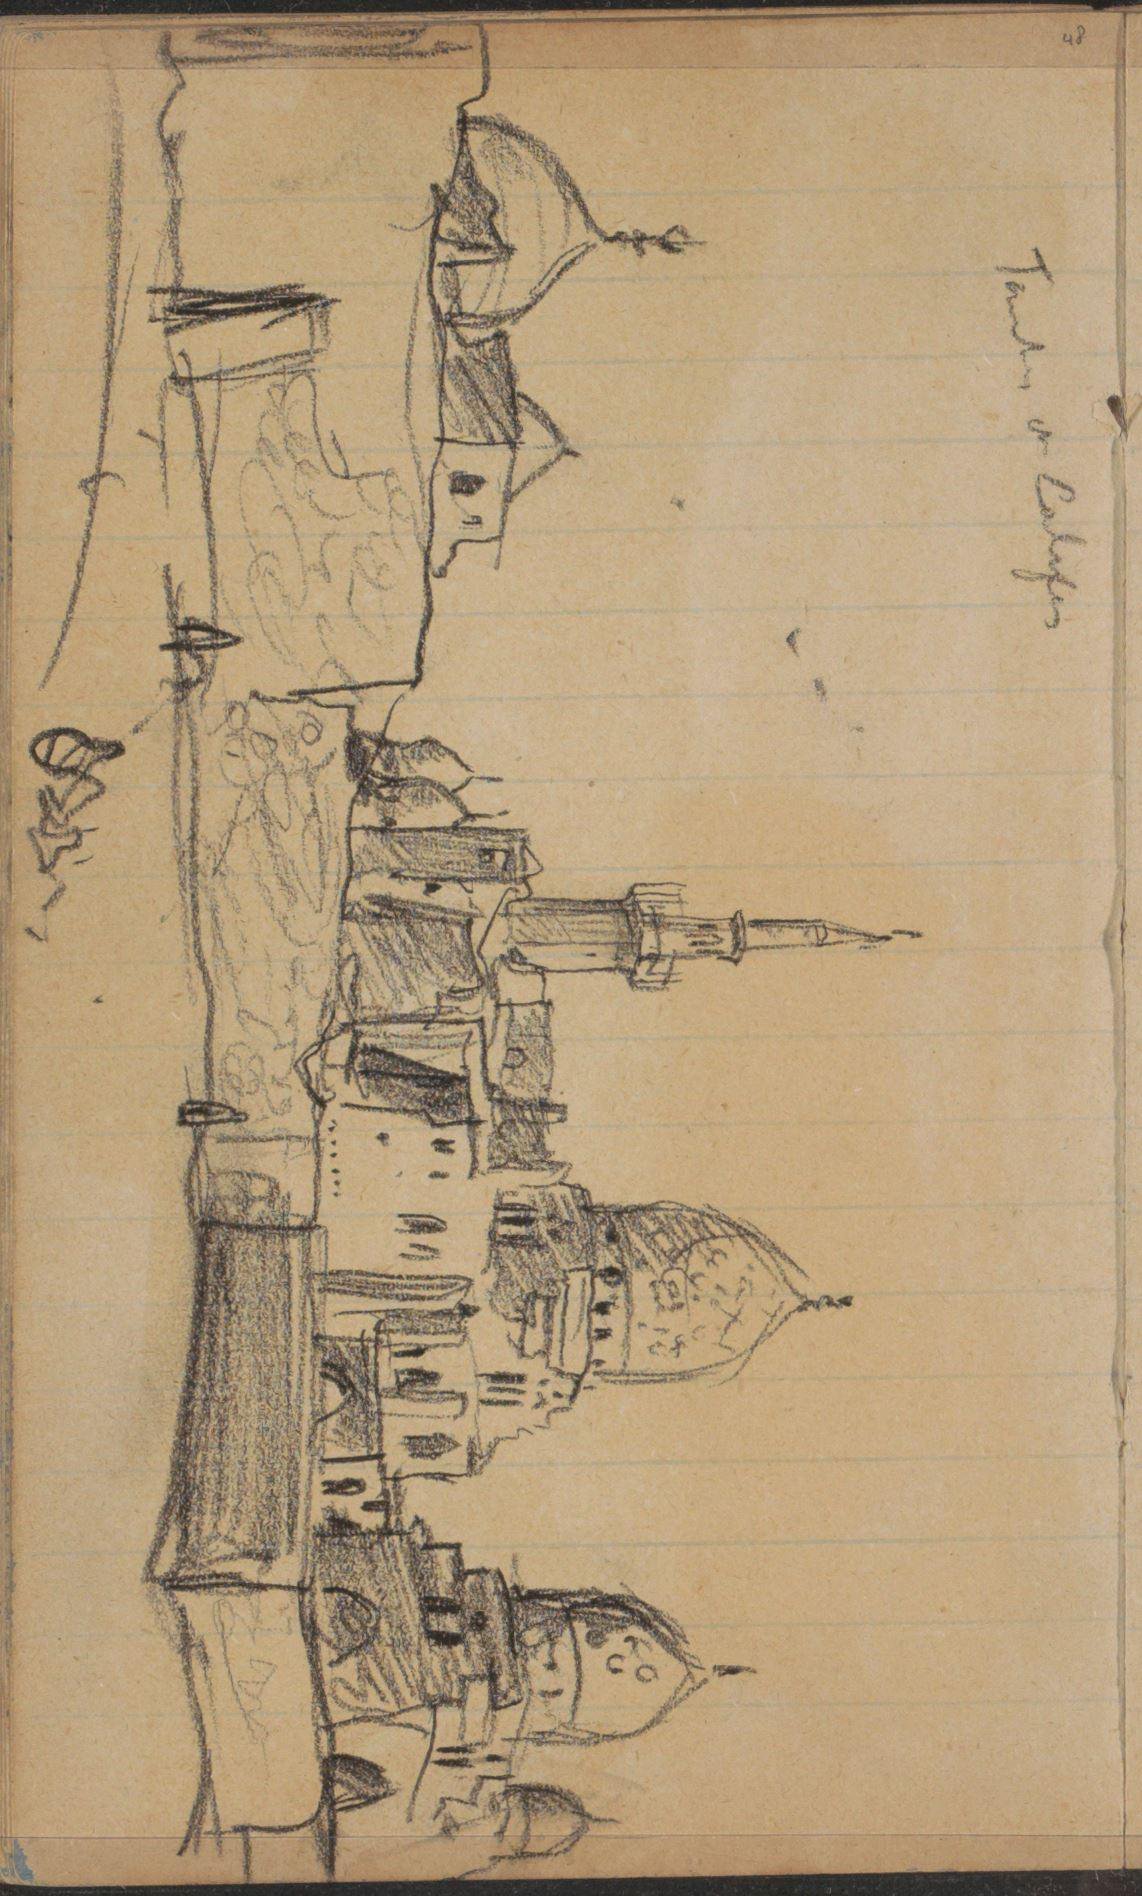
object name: sketchbook leaf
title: Graven der Kaliefen in Caïro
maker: marius bauer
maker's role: draughtsman, print maker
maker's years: 1867-1932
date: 1894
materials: chalk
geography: cairo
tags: grave-building, monumental tomb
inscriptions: annotation: ‘Tombes der Califen’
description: Pagina 48 uit een schetsboek met 48 bladen.